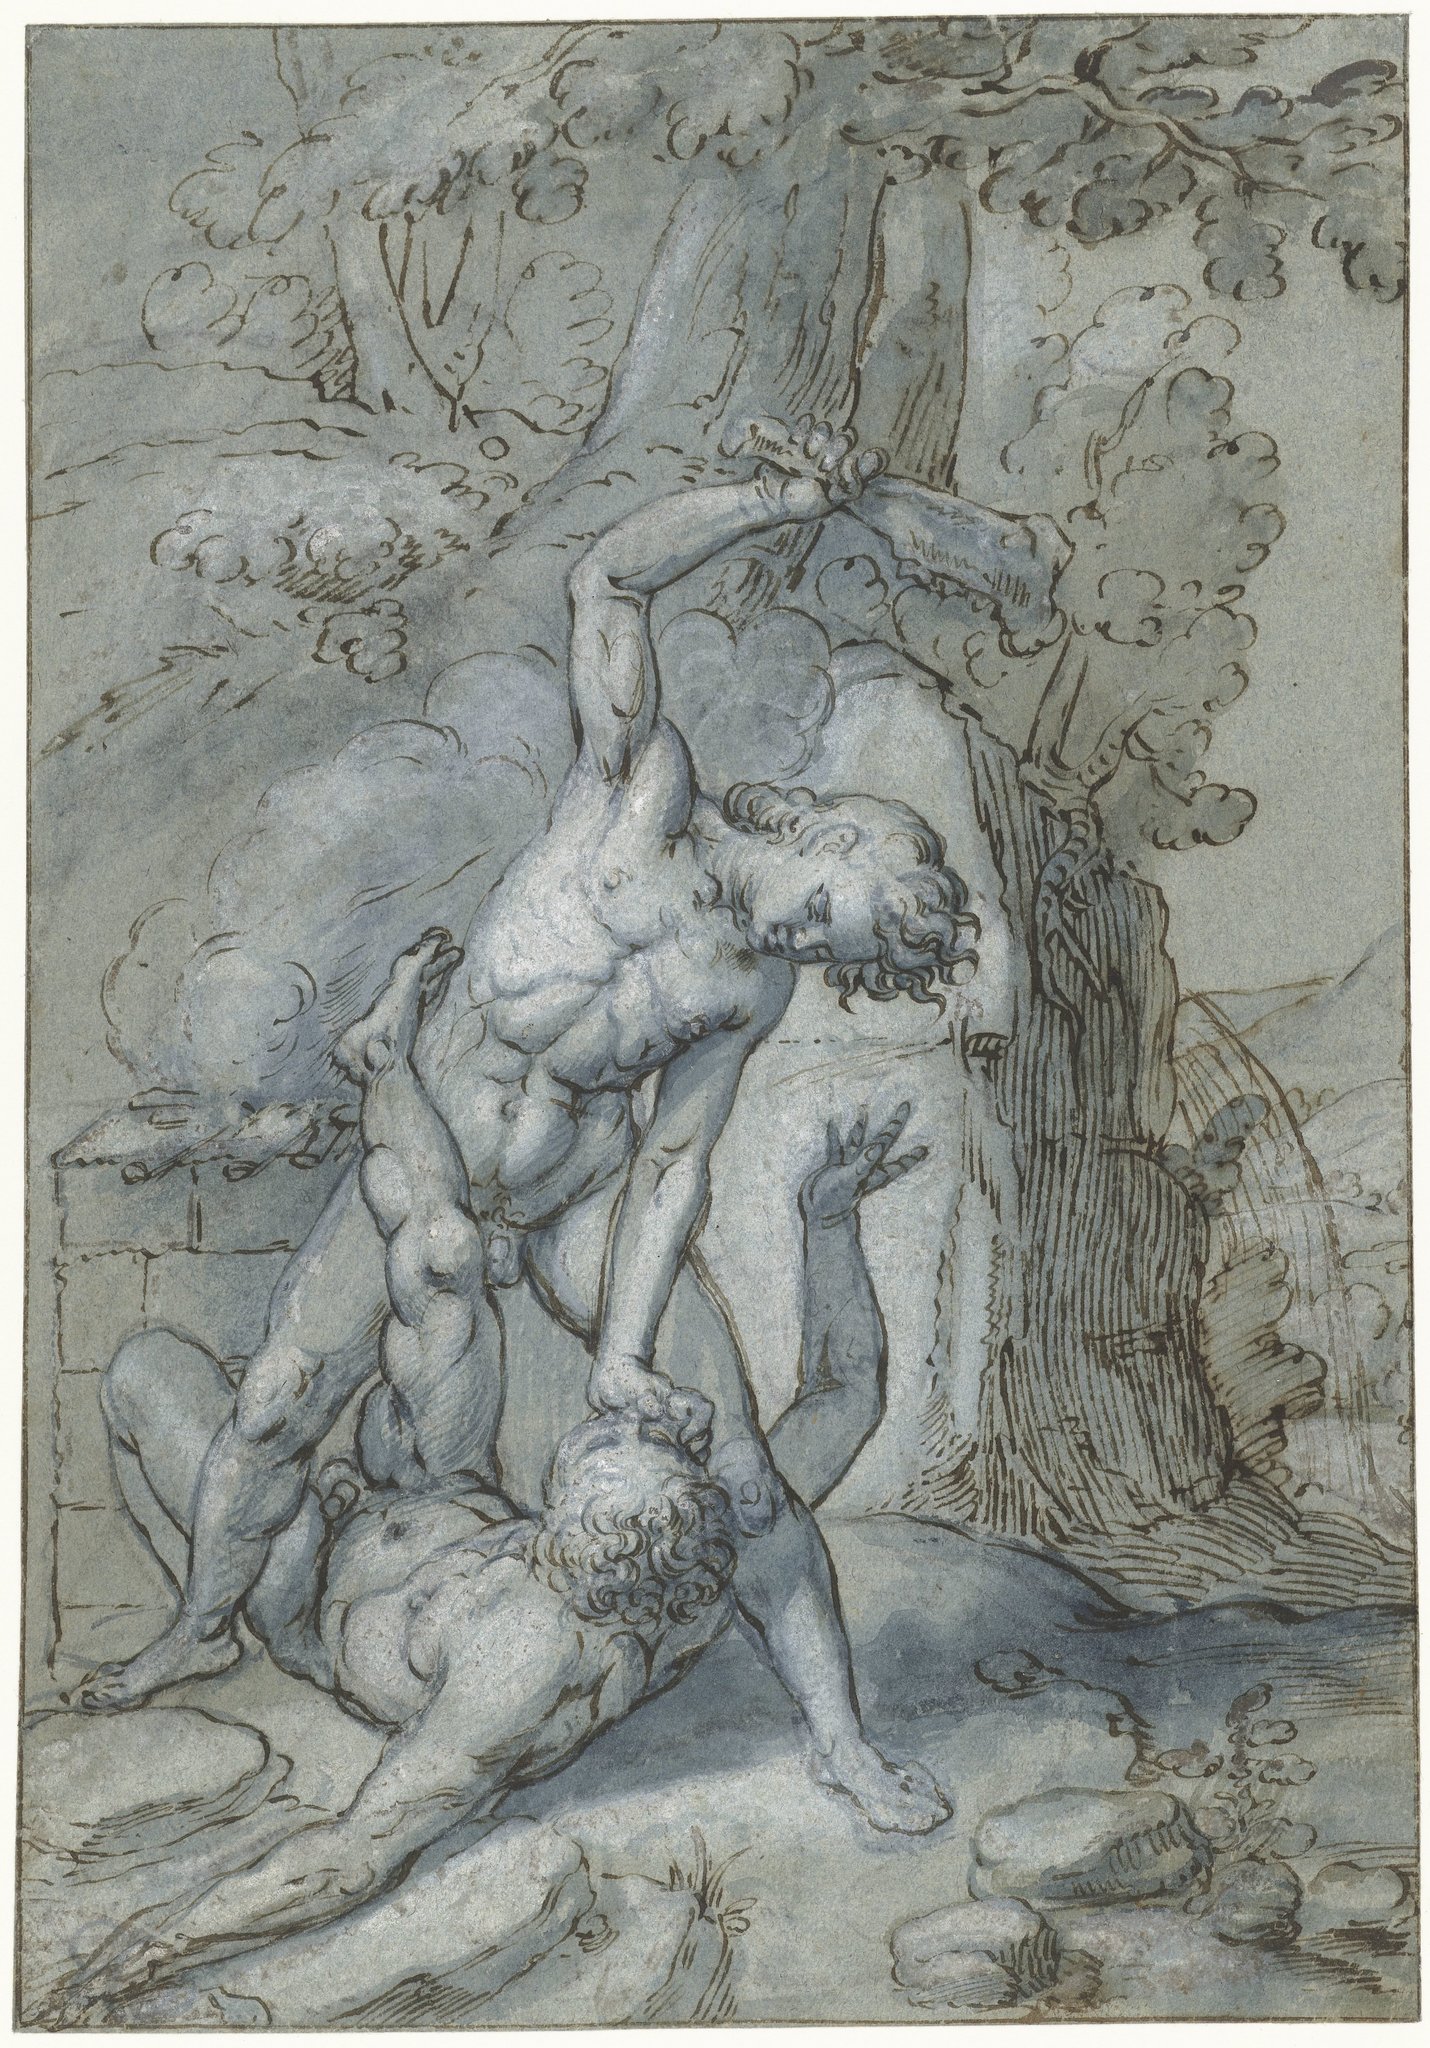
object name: drawing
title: Kain doodt Abel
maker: Anonymous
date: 1590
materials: ink, paint, paper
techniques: brush, pen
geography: low countries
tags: the killing of abel: cain slays him with a stone, a club or a jaw-bone, alternatively with a spade or another tool as weapon